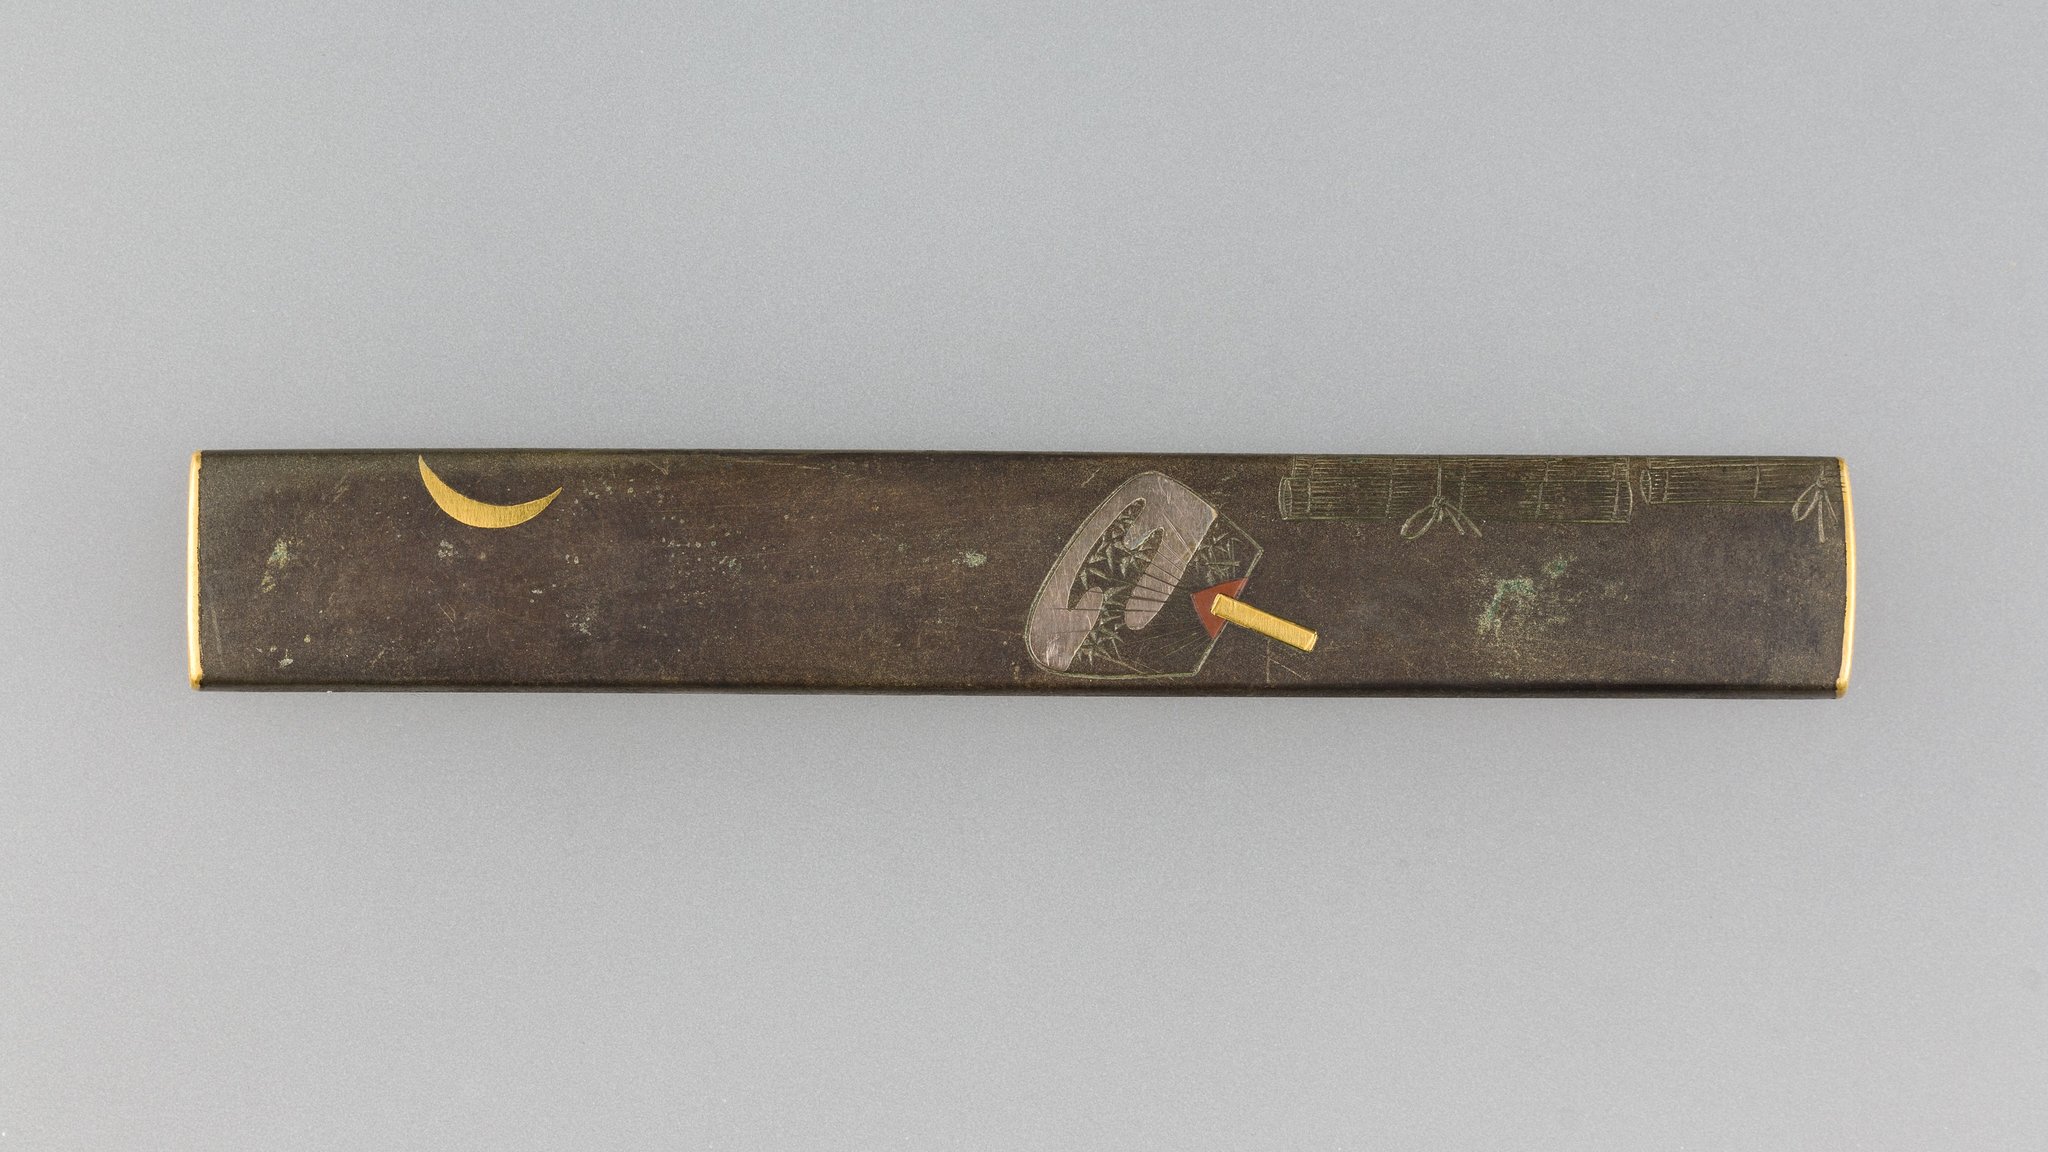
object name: knife handle kozuka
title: Knife Handle (Kozuka)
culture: japanese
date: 1789-1876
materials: copper, silver alloy, gold, silver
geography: japan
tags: fans